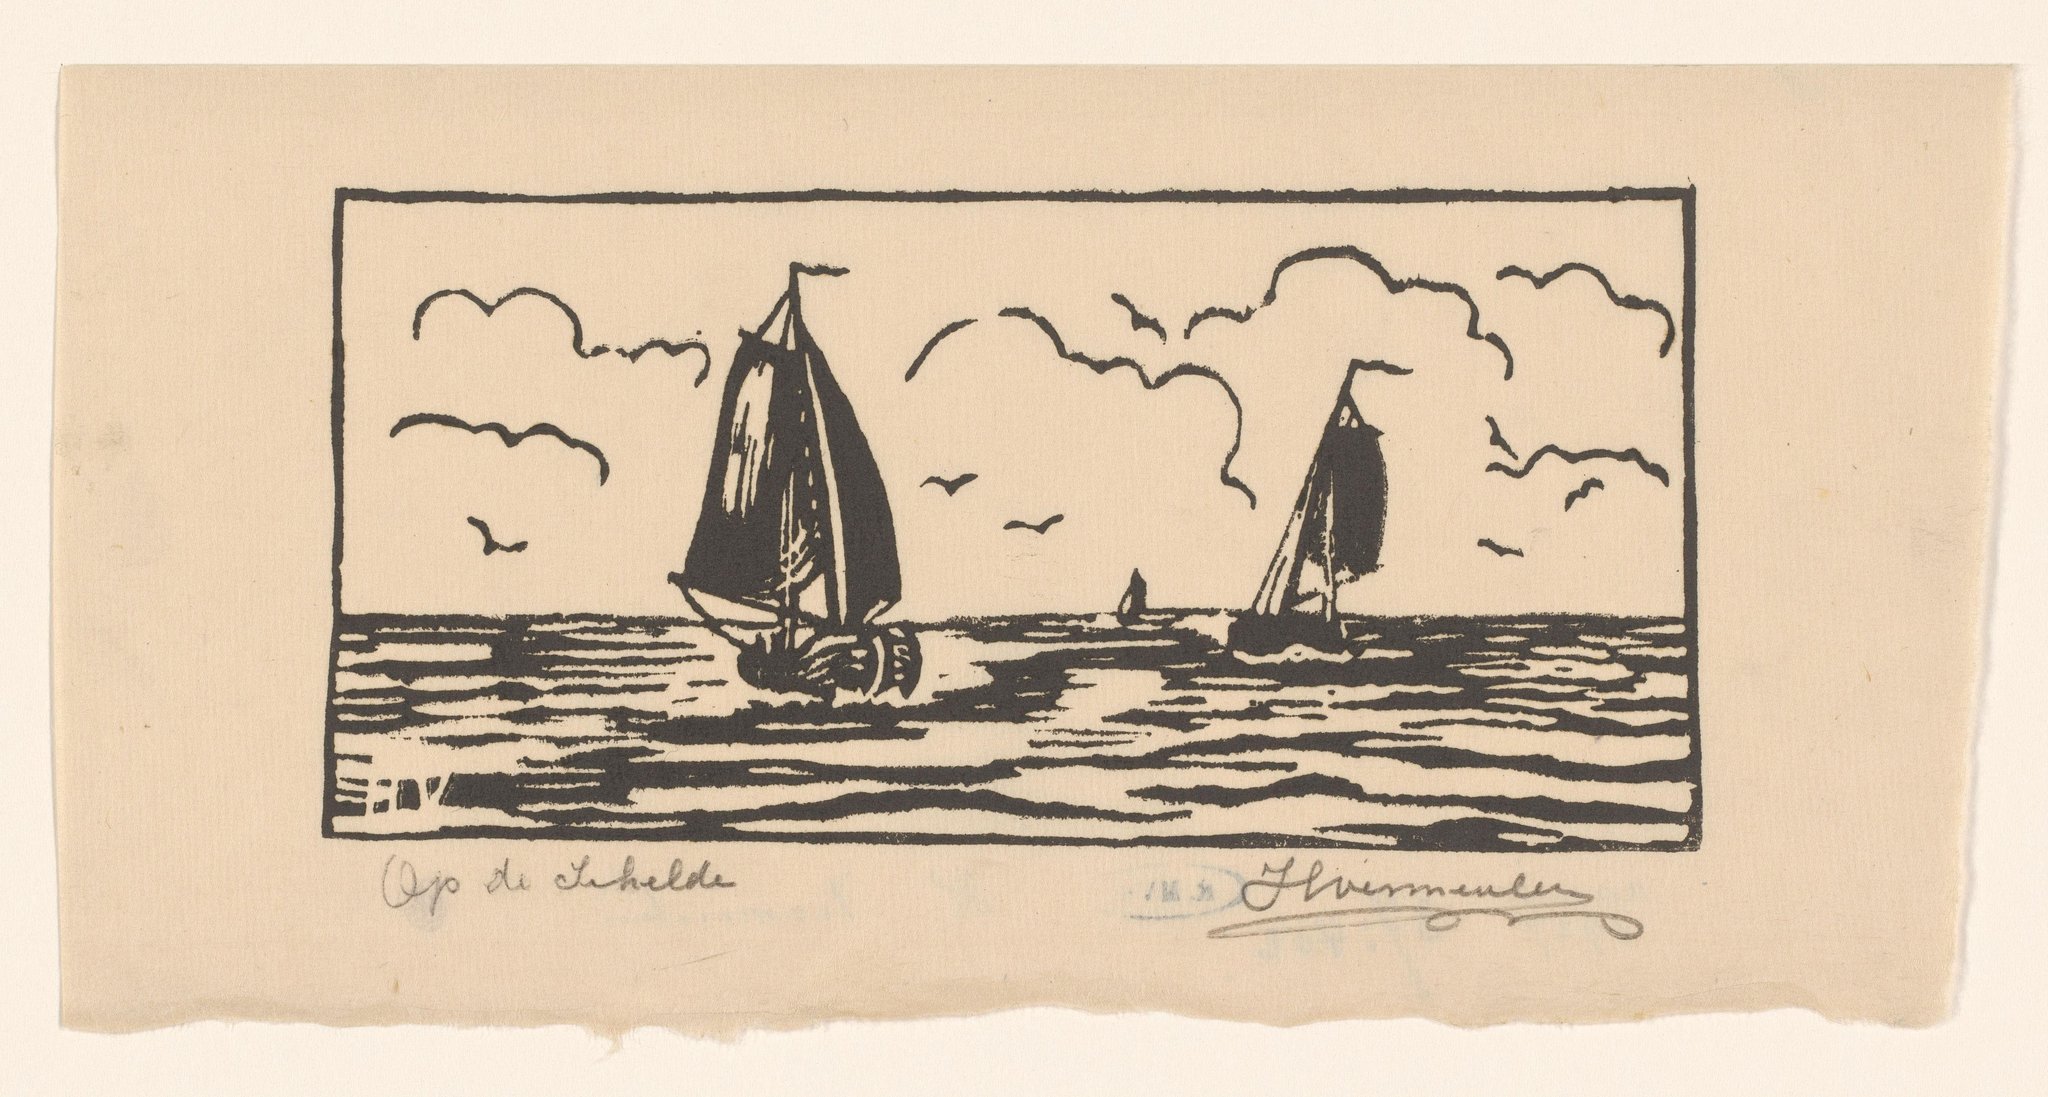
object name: print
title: Op de Schelde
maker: h. vermeulen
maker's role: publisher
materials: paper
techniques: woodcut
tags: sailing-ship, sailing-boat, traffic on the water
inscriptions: collector's mark: Lugt 2228, collector's mark: Lugt 2760